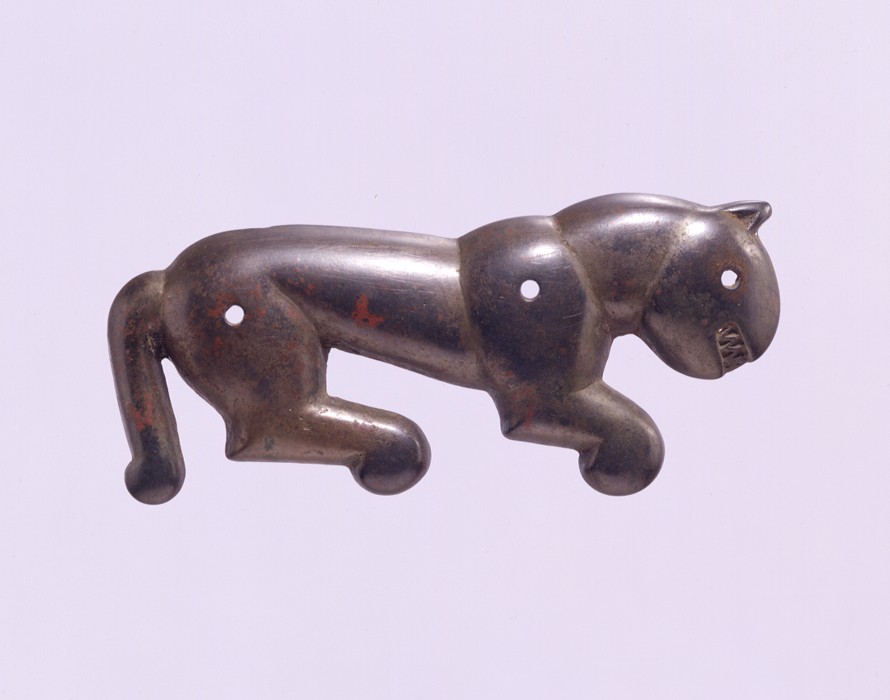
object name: pectoral ornament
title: Leopard-Shaped Pectoral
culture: chinese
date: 600-501 BCE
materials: bronze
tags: leopards